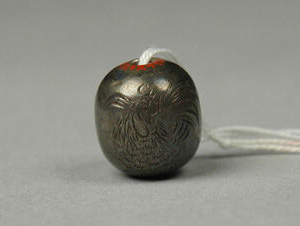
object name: ojime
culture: japanese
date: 1801-1900